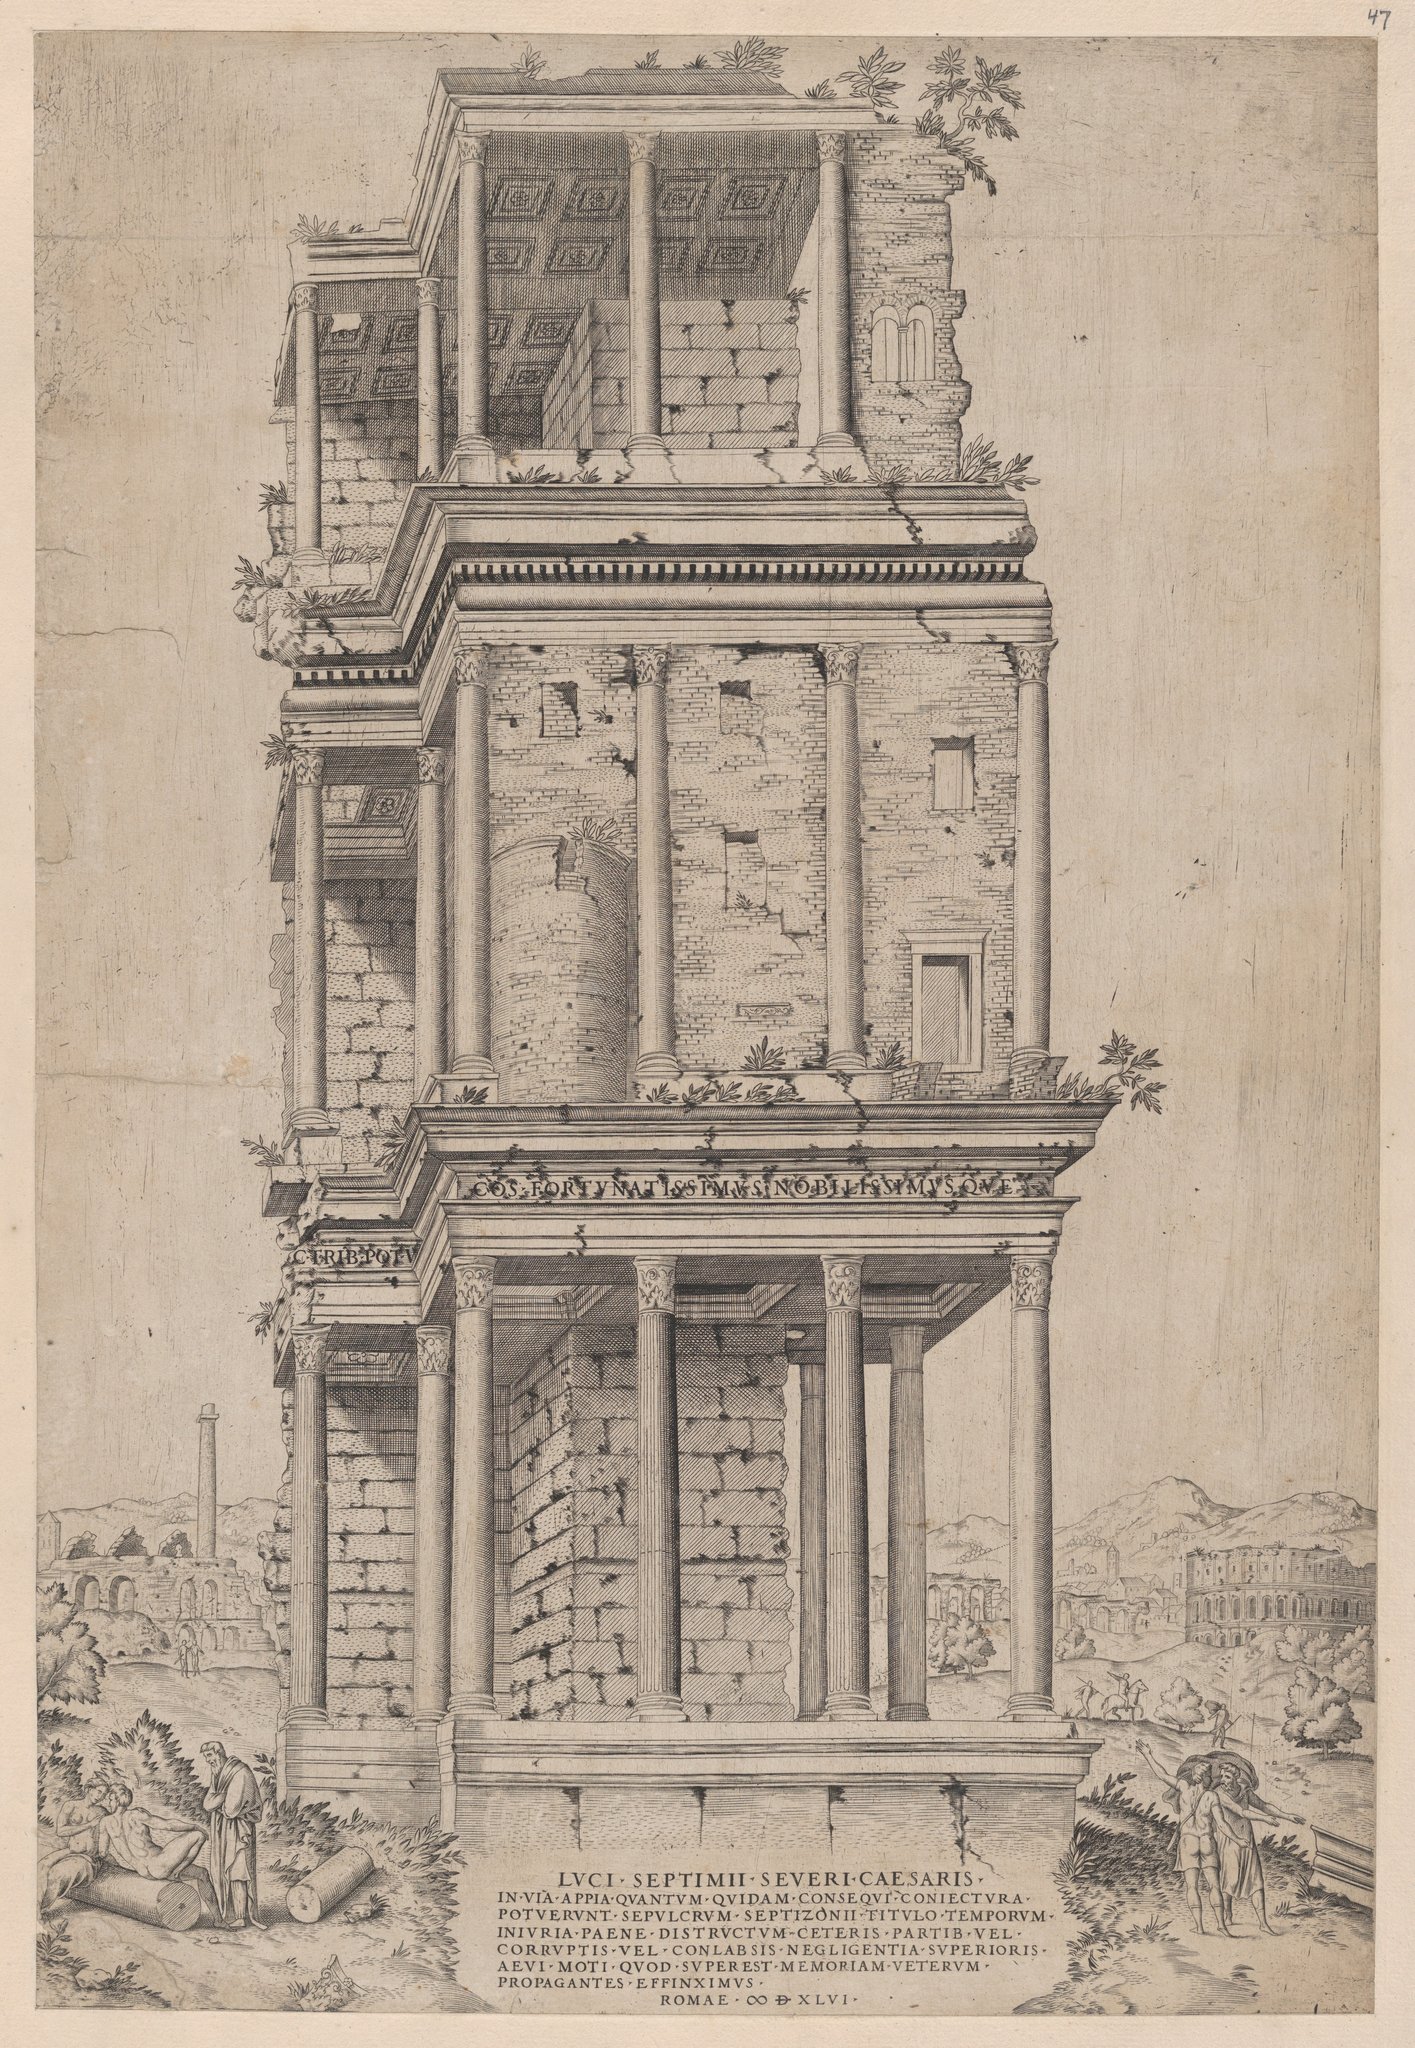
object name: print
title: The Septizodium, from "Speculum Romanae Magnificentiae"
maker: Anonymous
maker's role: artist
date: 1556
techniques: engraving, etching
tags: buildings,ruins,rome